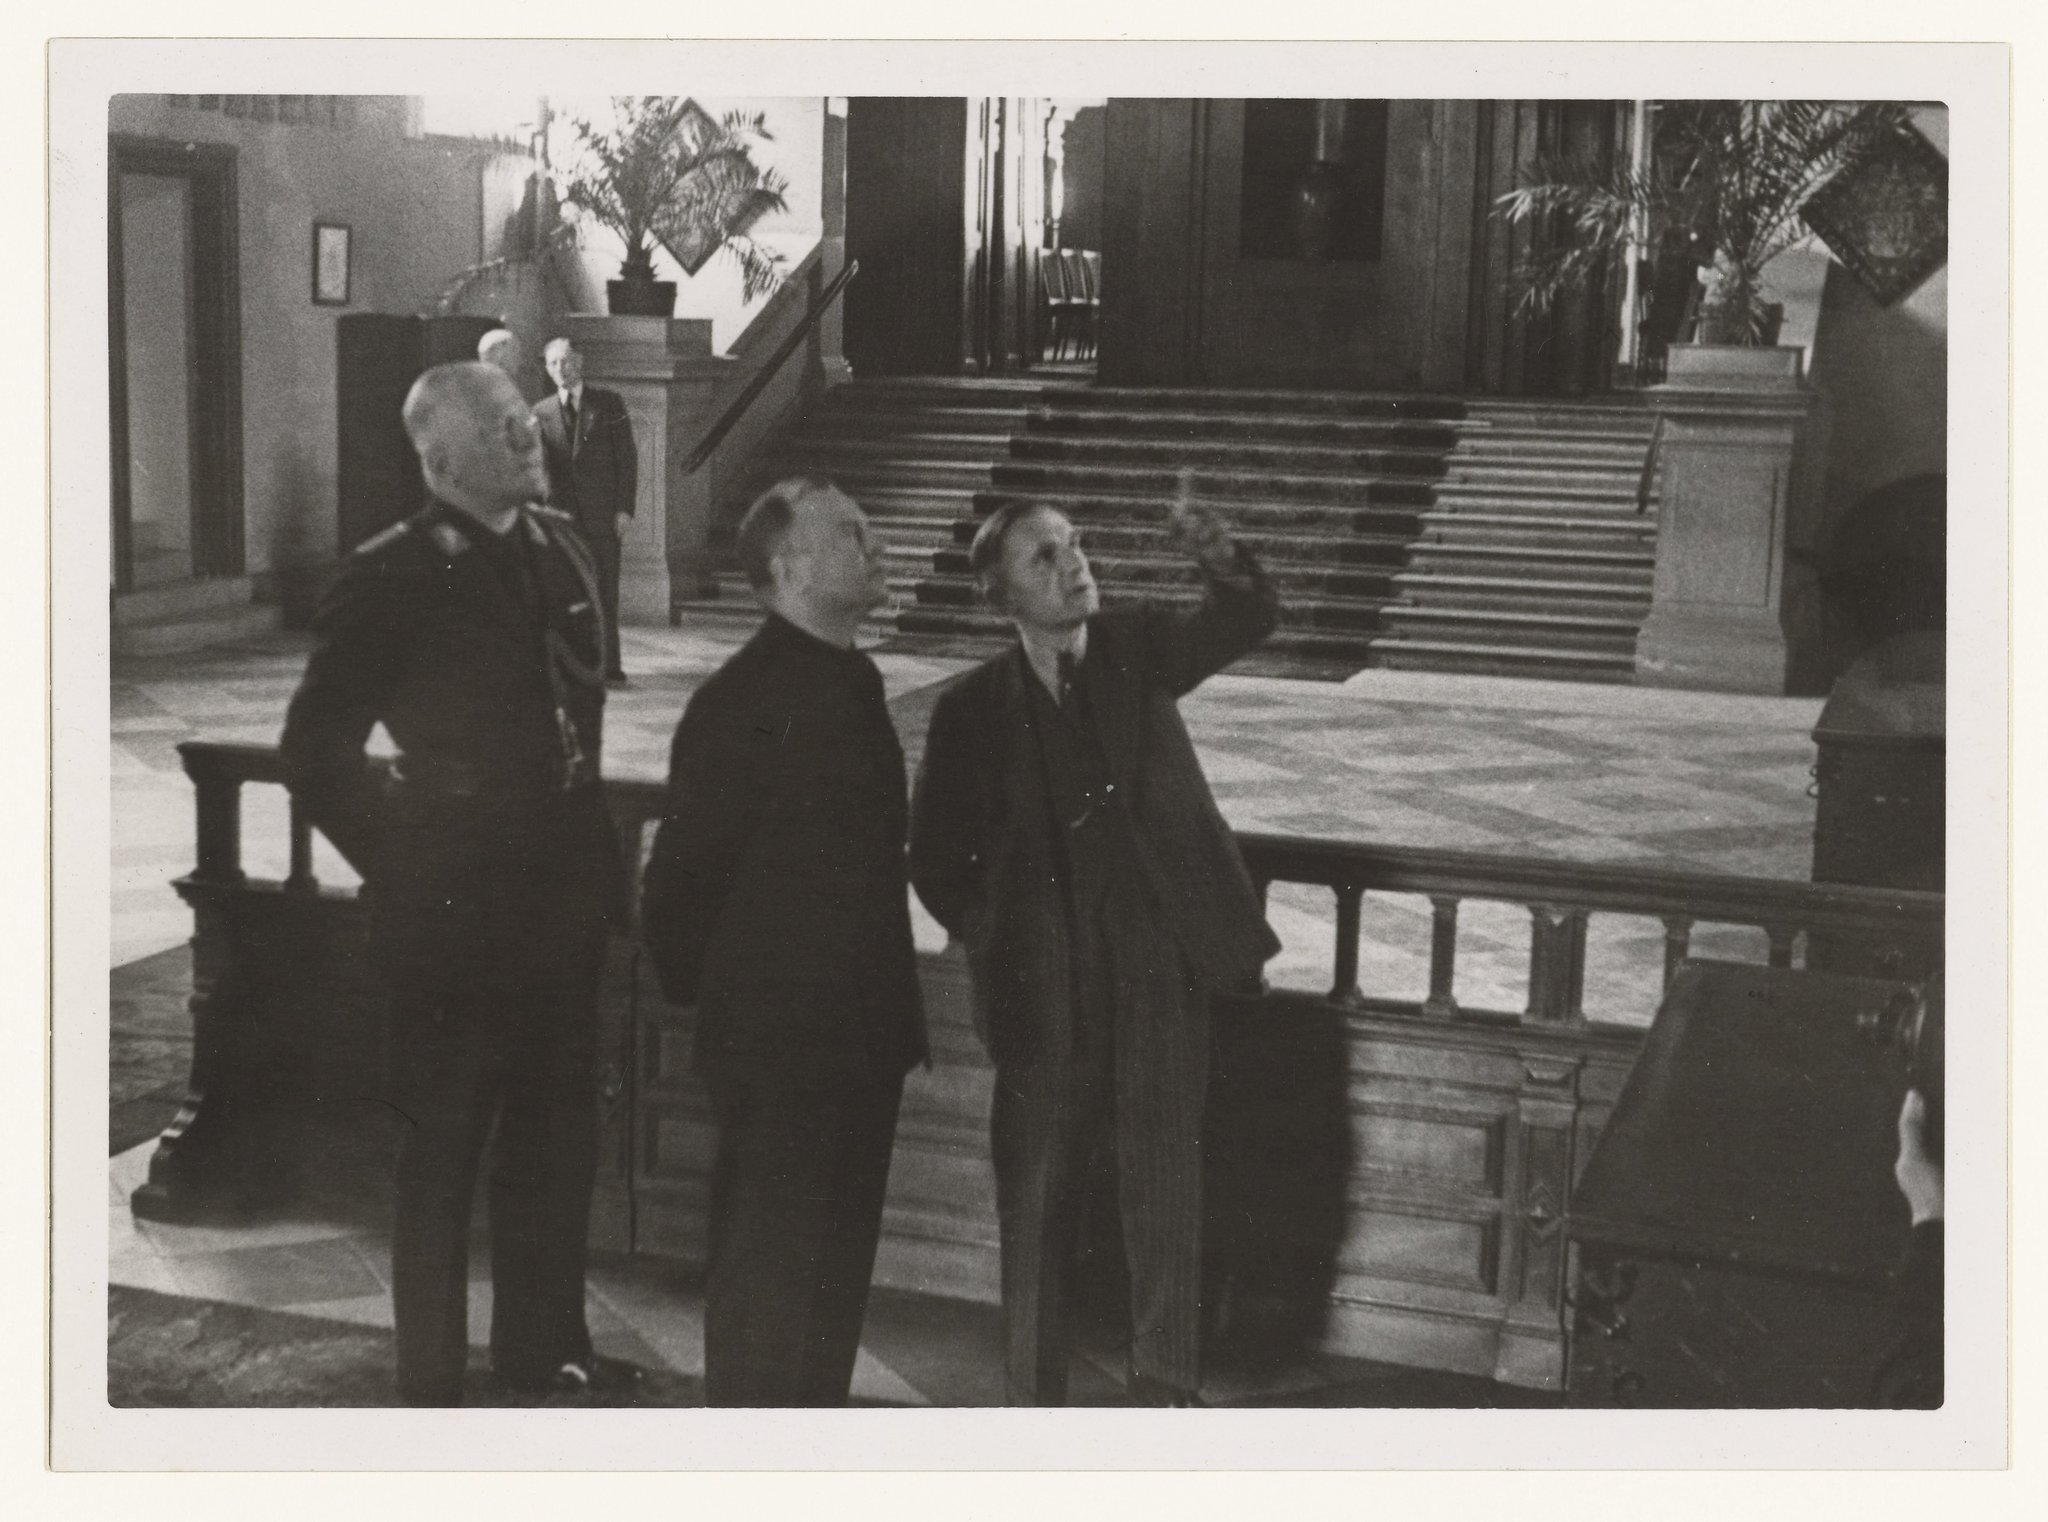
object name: photograph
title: Bezoek Mussert aan Haarlem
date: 1941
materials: photographic support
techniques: gelatin silver print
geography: haarlem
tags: leiden, amsterdam, painter, print maker, draughtsman, rembrandt van rijn, the hague, politician, anton adriaan mussert, haarlem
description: Mussert brengt een bezoek aan Haarlem en wordt ontvangen op het stadhuis door de NSB burgemeester S.L.A. Plekker, lid sinds 1932 en sinds 10 maart 1941 burgemeester van Haarlem. Achter Mussert zijn adjudant Kessler. De heren staan in de hal en de burgemeester wijst Mussert iets aan.